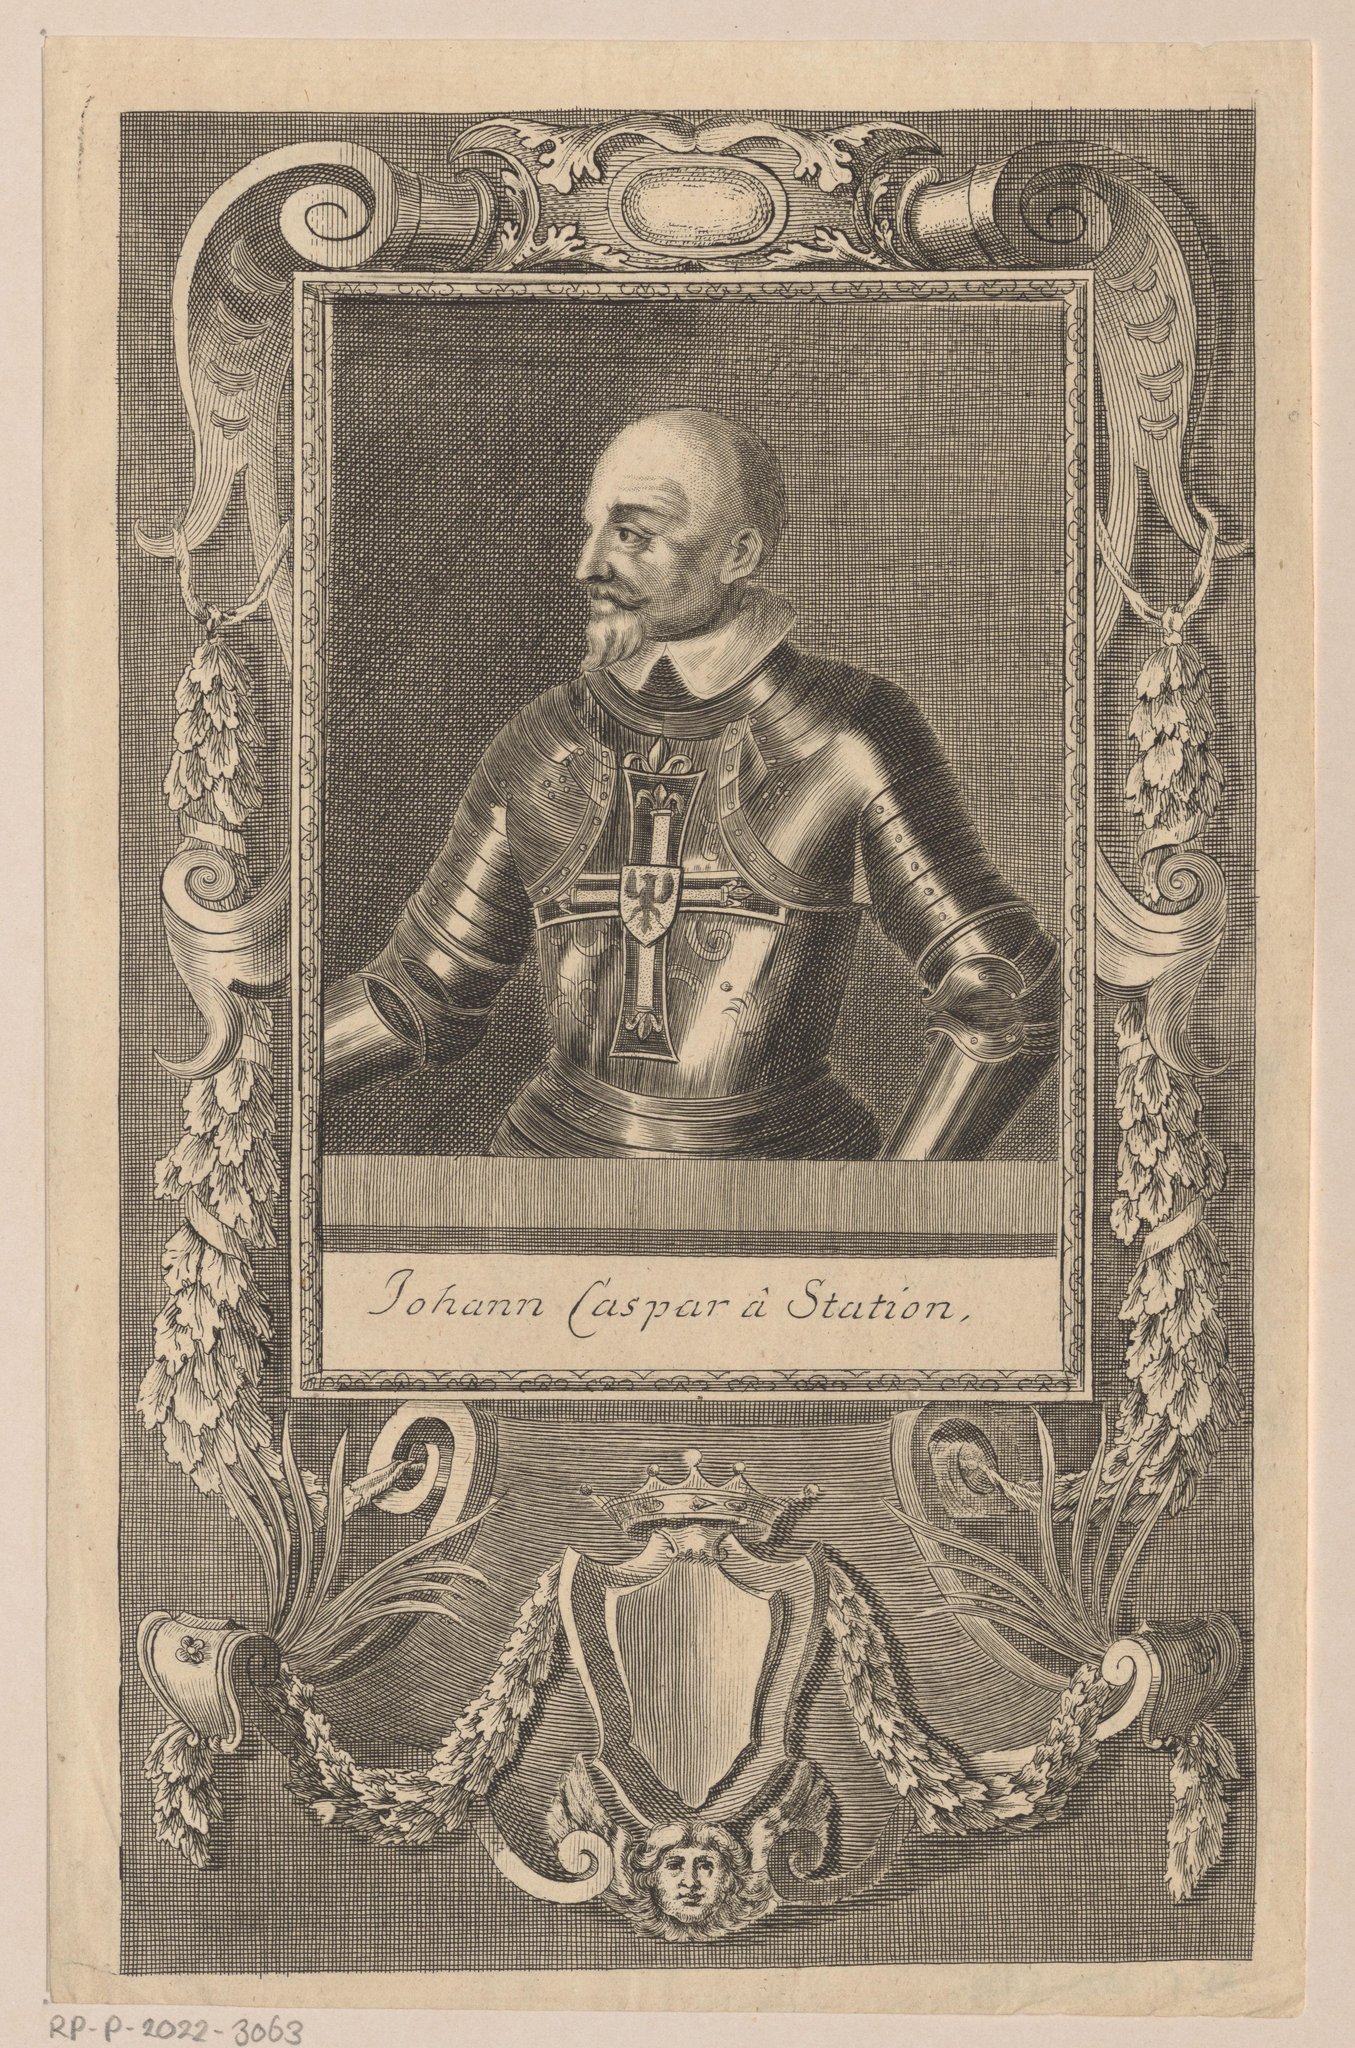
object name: print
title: Portret van Johann Kaspar von Stadion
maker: Anonymous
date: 1722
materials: paper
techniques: engraving, etching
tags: historical persons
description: Prent met andere omlijsting gebruikt in: Conterfet Kupfferstich (soviel man deren zu handen bringen können) deren jenigen regierenden grossen Herren (...). Leipzig: Moritz Georg Weidmann, 1722.